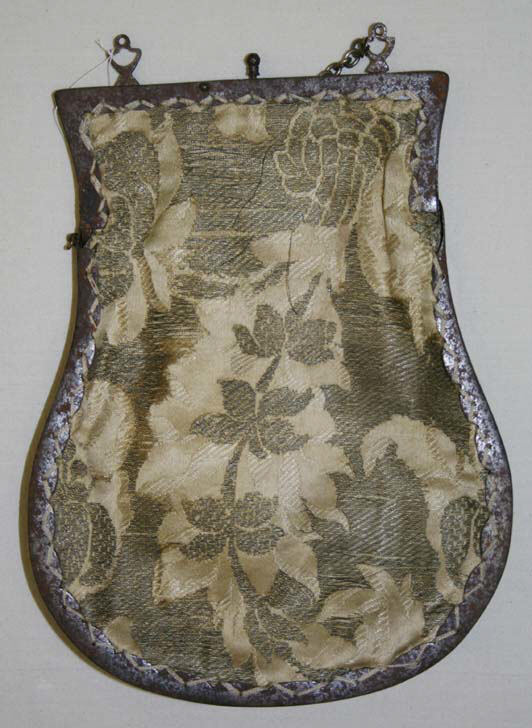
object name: bag chatelaine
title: Chatelaine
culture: italian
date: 1801-1900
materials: metal, silk